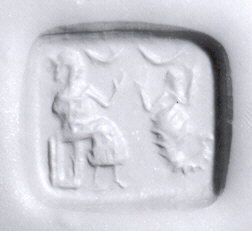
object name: stamp seal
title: Rectangular plaque seal with stepped pyramidal back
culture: akkadian or neo-sumerian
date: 2250-2000 BCE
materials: stone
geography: mesopotamia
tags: women,scorpions